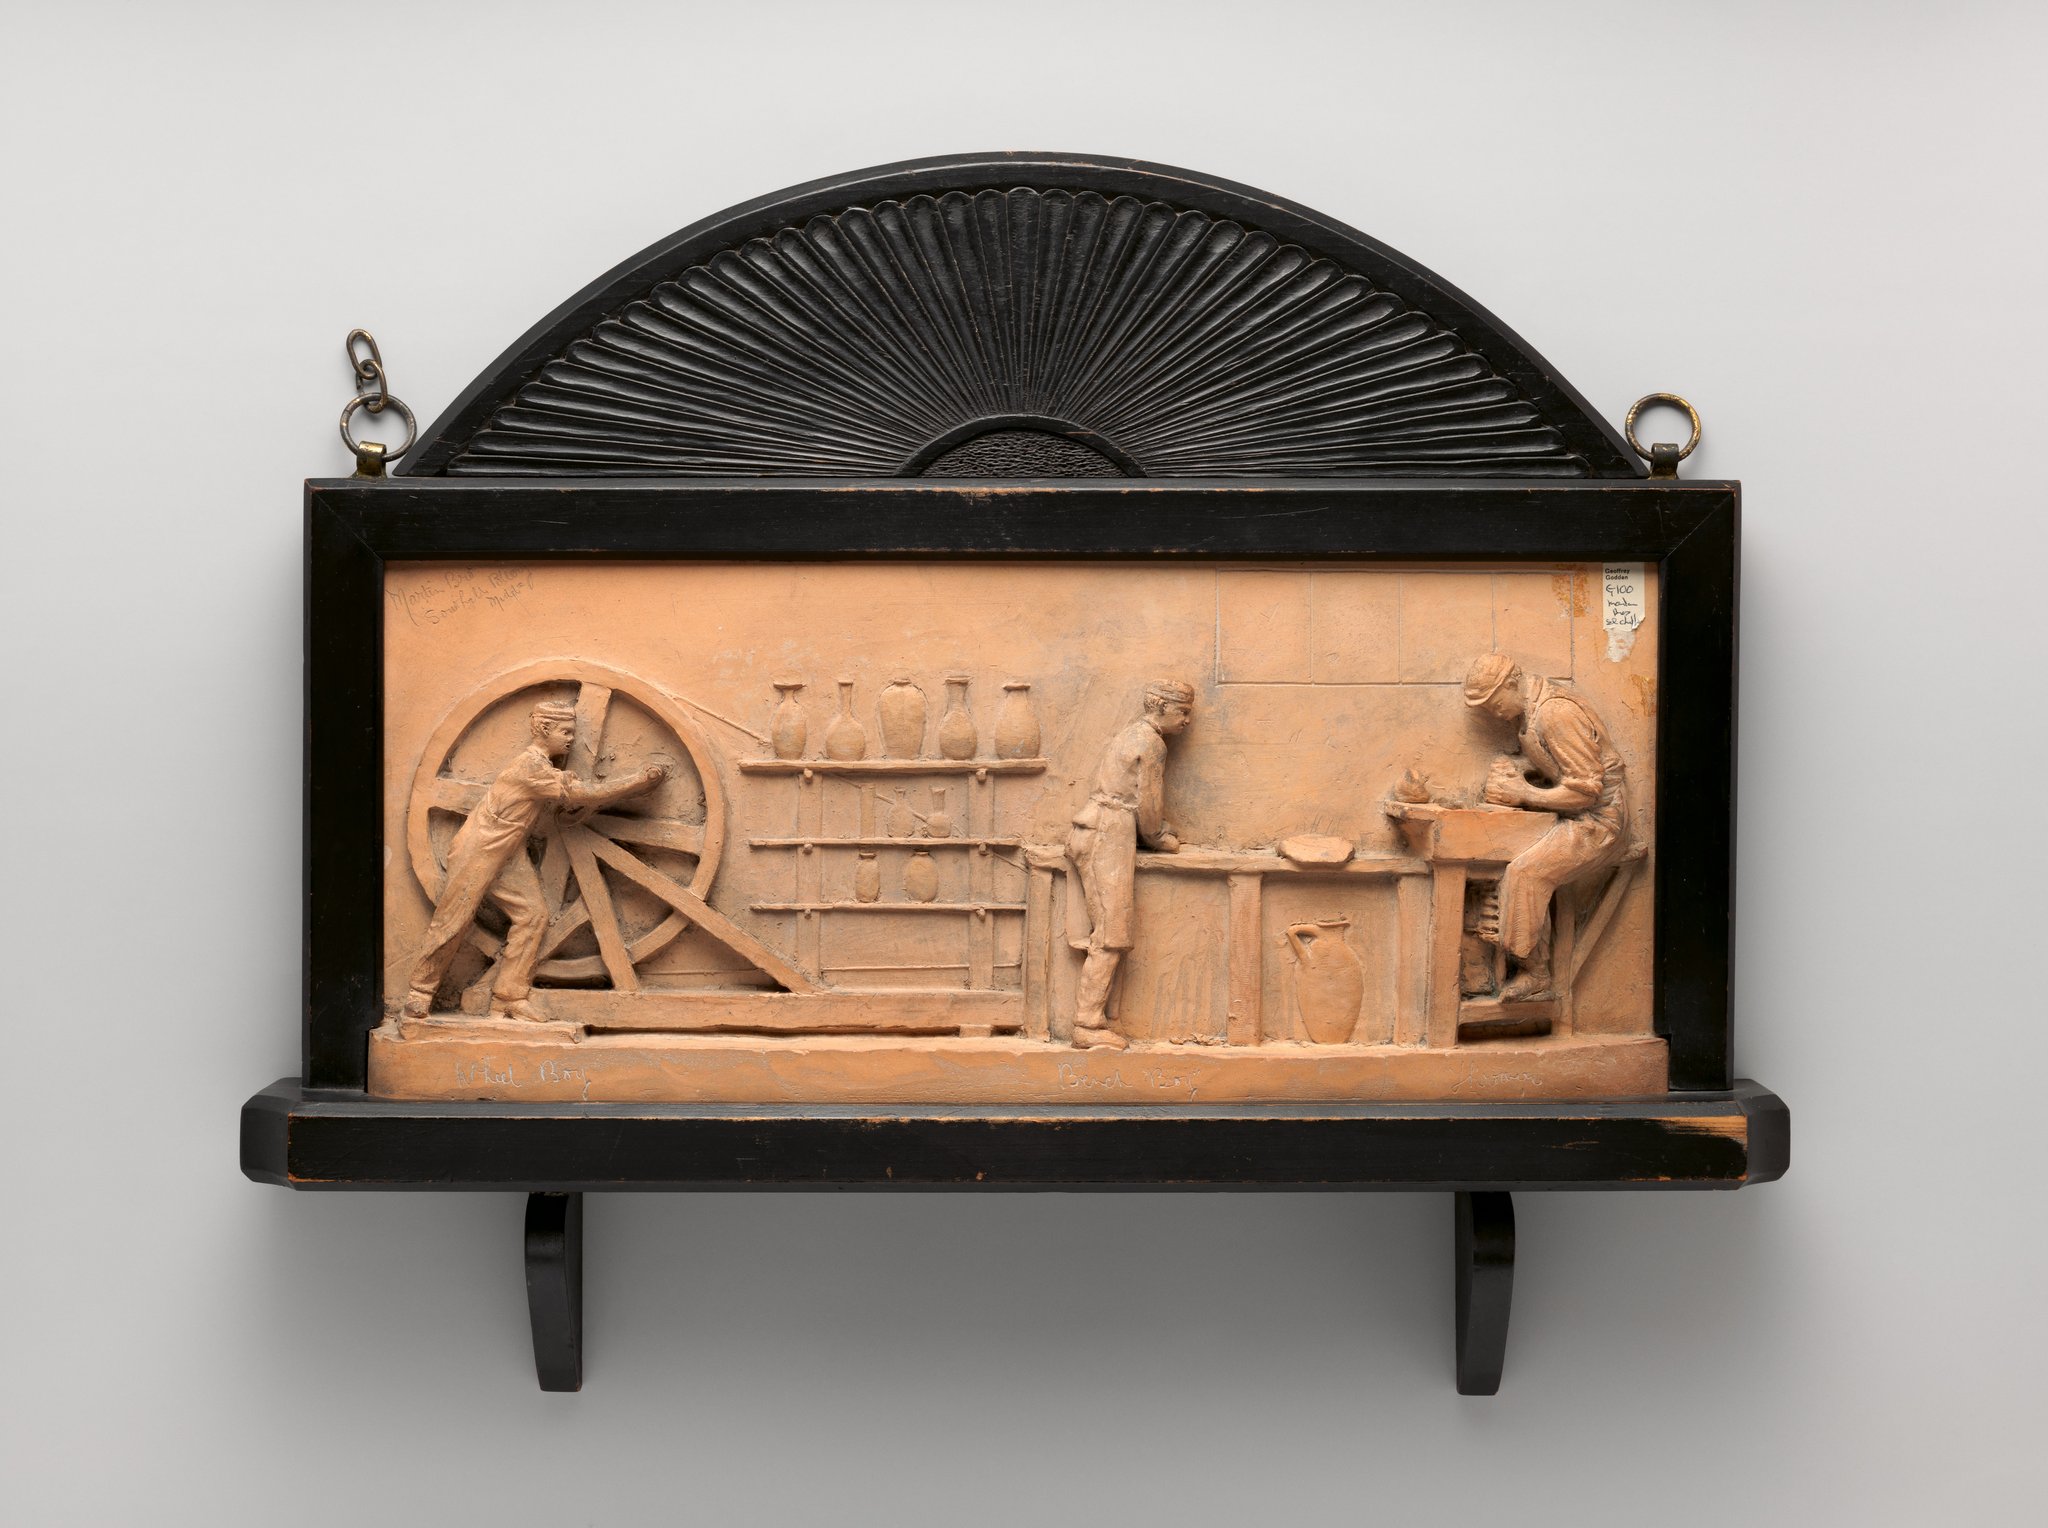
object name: plaque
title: Plaque depicting a pottery workshop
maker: r. w. martin and brothers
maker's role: maker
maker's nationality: british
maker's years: 1873-1915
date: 1882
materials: terracotta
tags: men,working